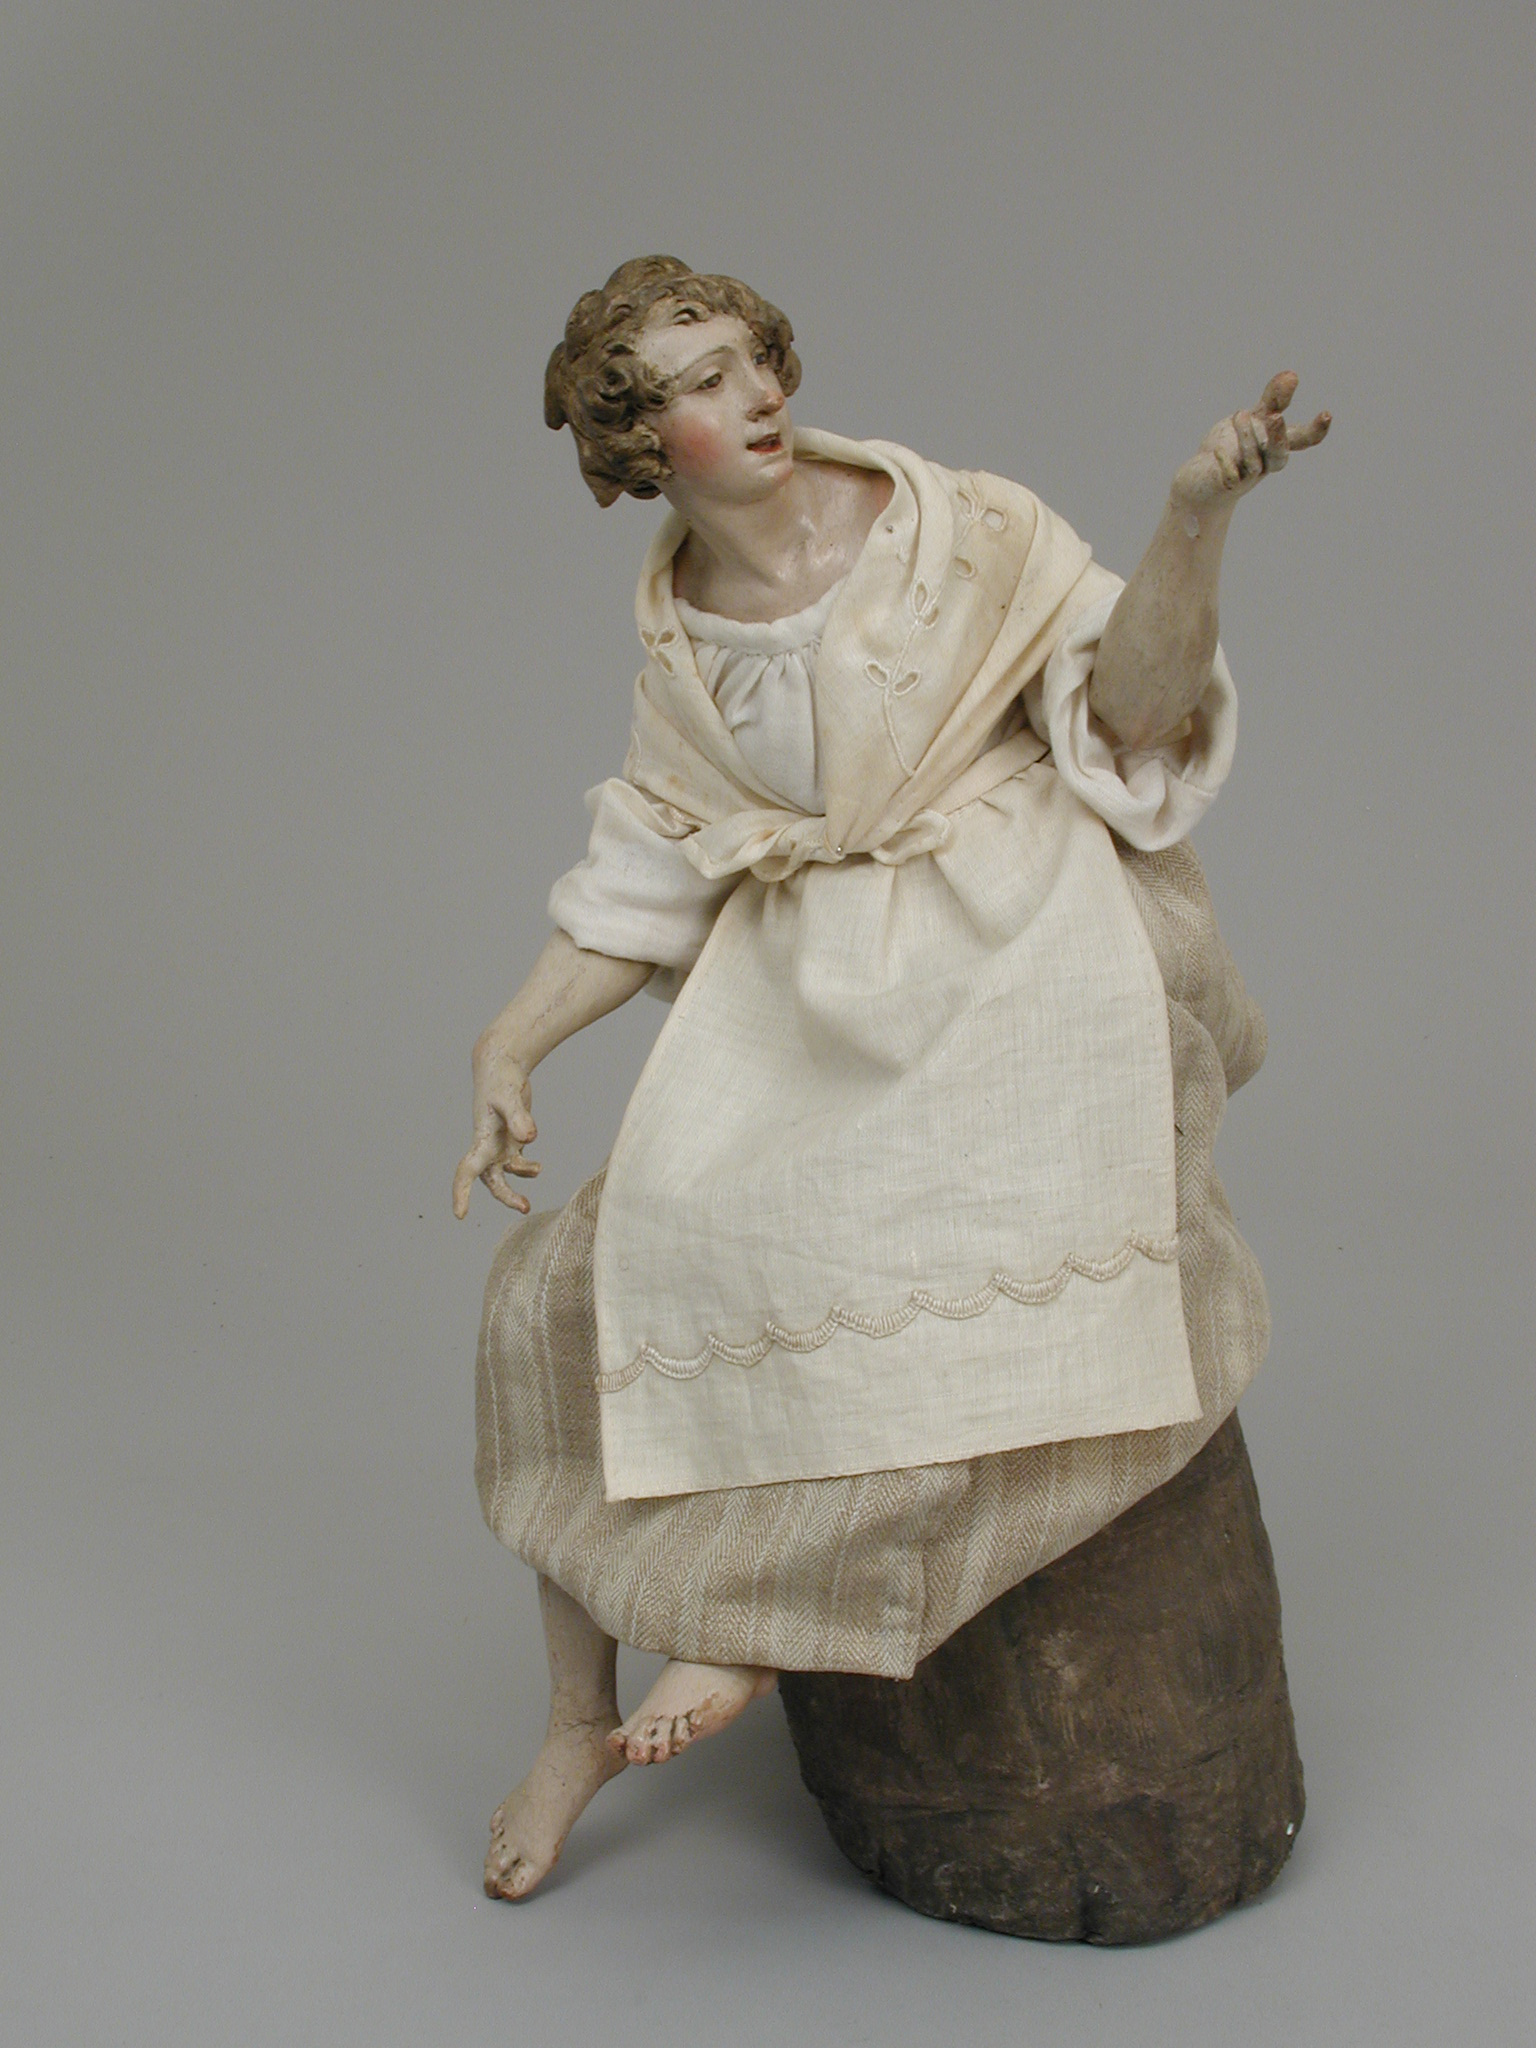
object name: crèche figure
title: Angel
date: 1767-1833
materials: silk, terracotta, fiber, velvet, metal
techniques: polychrome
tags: angels